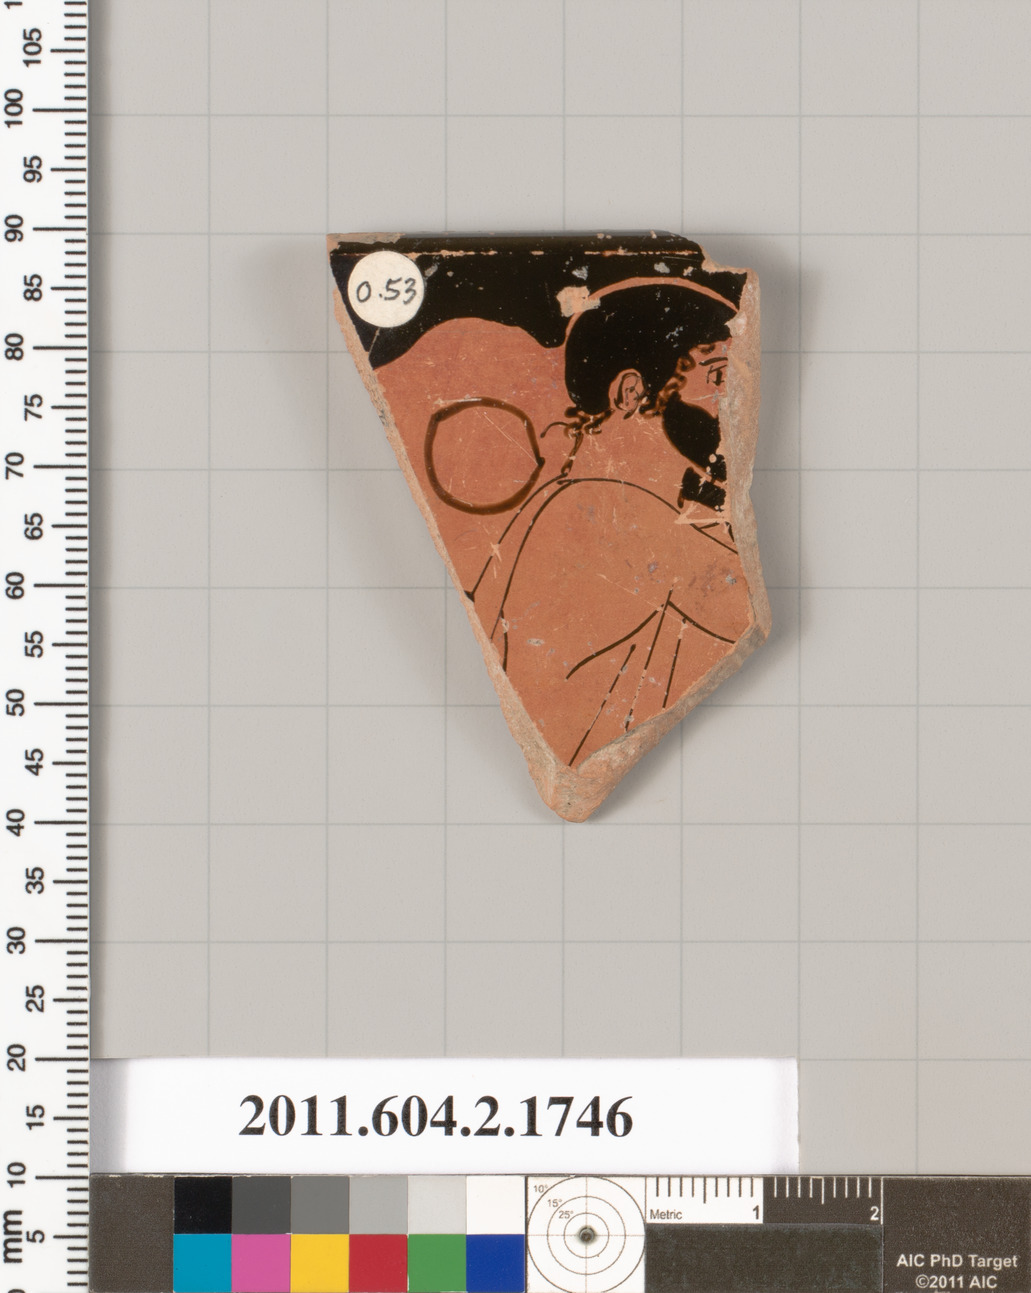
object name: skyphos fragment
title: Terracotta rim fragment of a skyphos (deep drinking cup)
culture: greek, attic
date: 450-426 BCE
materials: terracotta